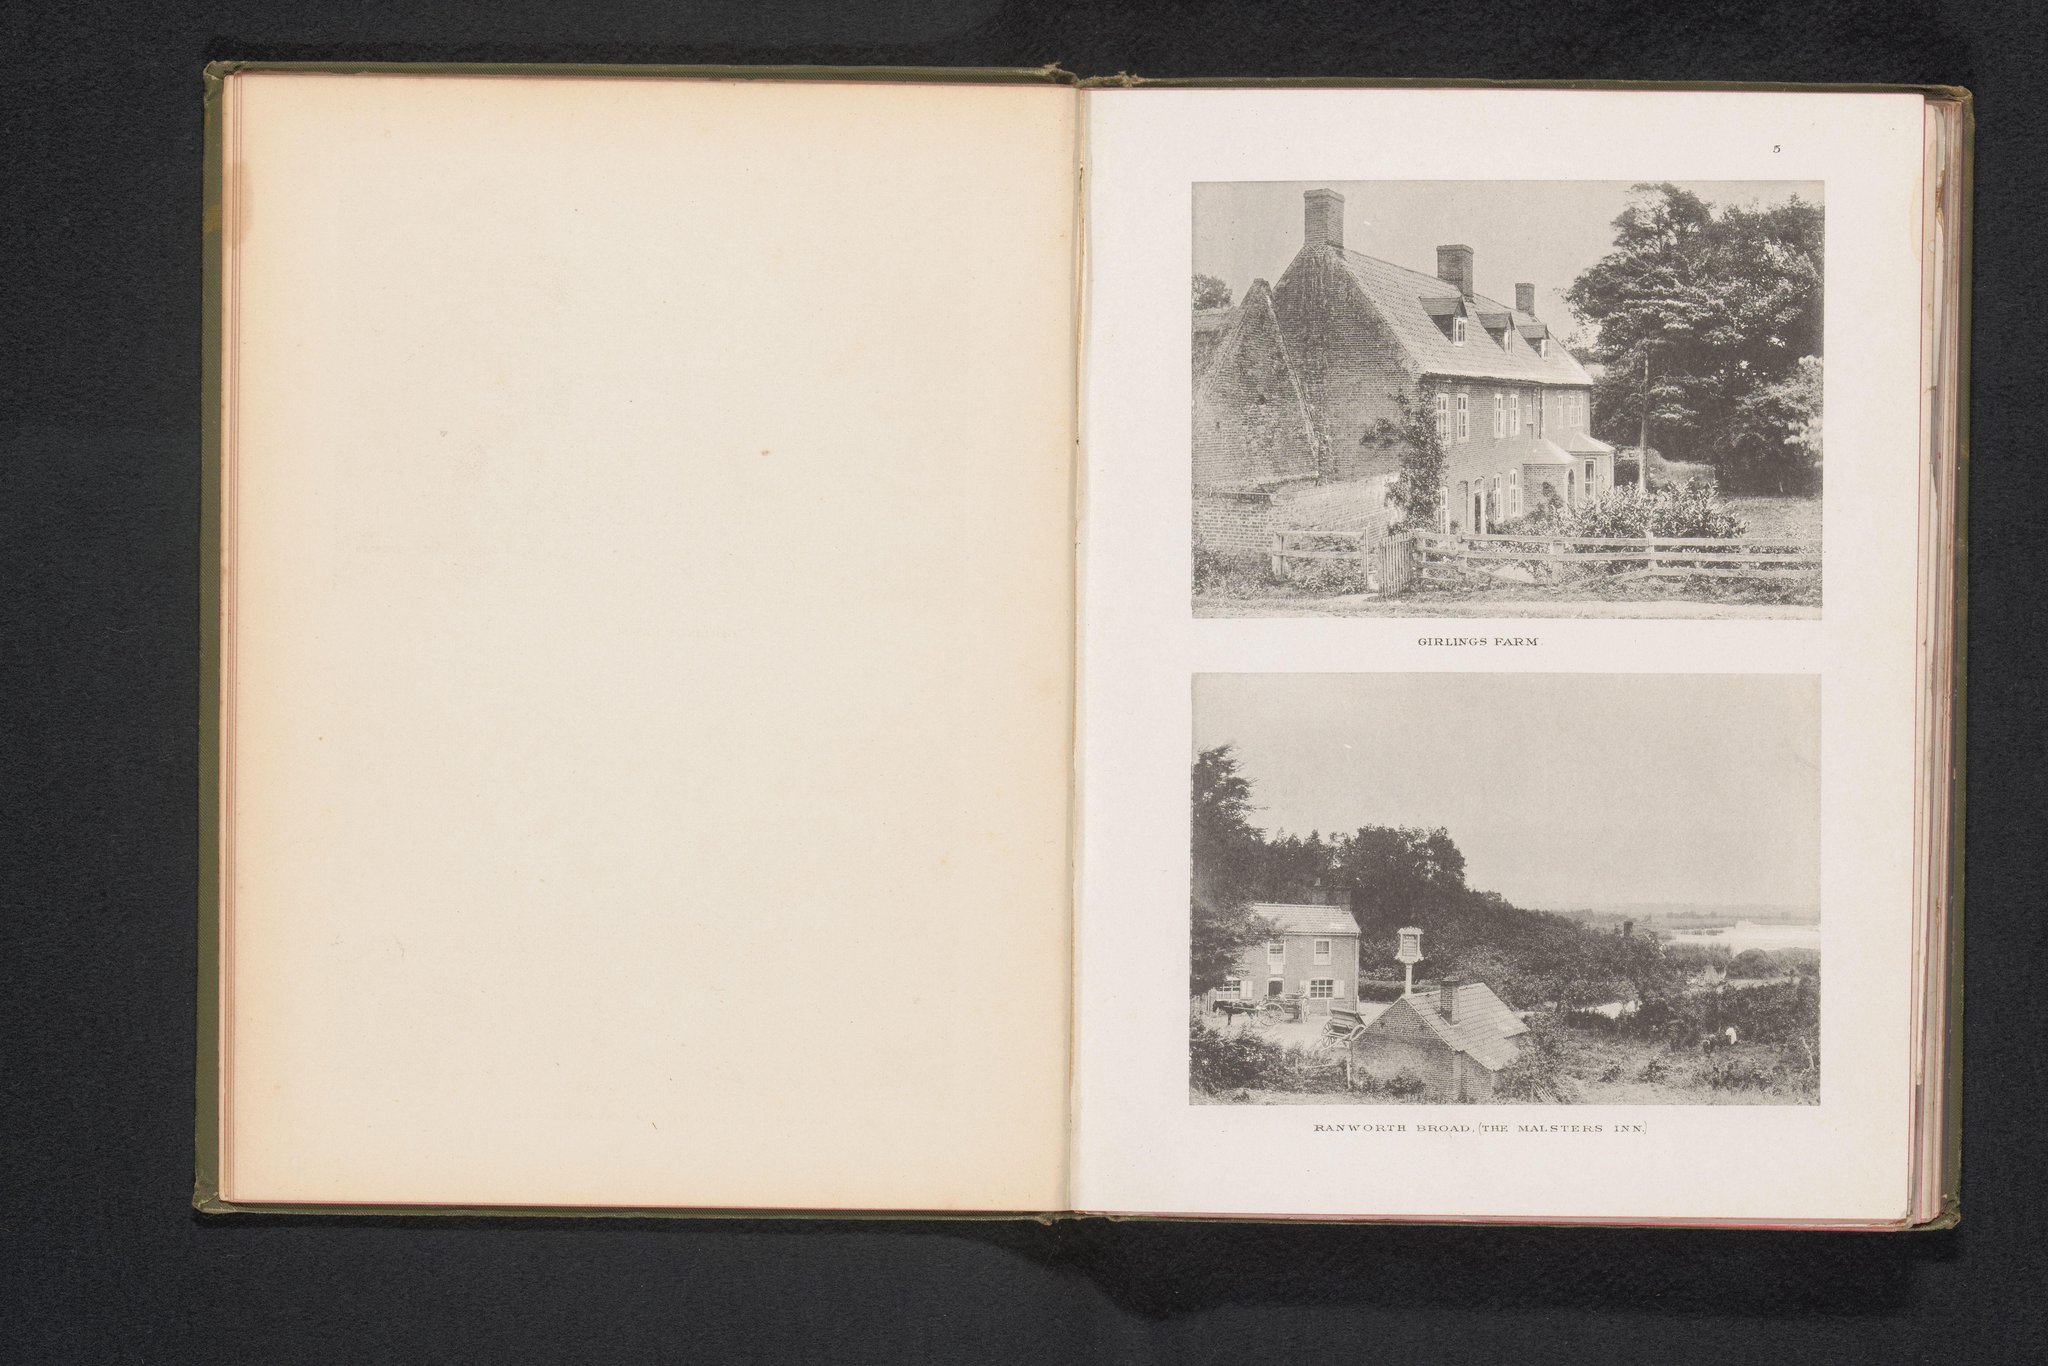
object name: photomechanical print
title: Boerderij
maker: john payne jennings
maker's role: fotograaf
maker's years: 1843-1926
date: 1886-1891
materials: paper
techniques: photograph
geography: norfolk broads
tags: farm (building)